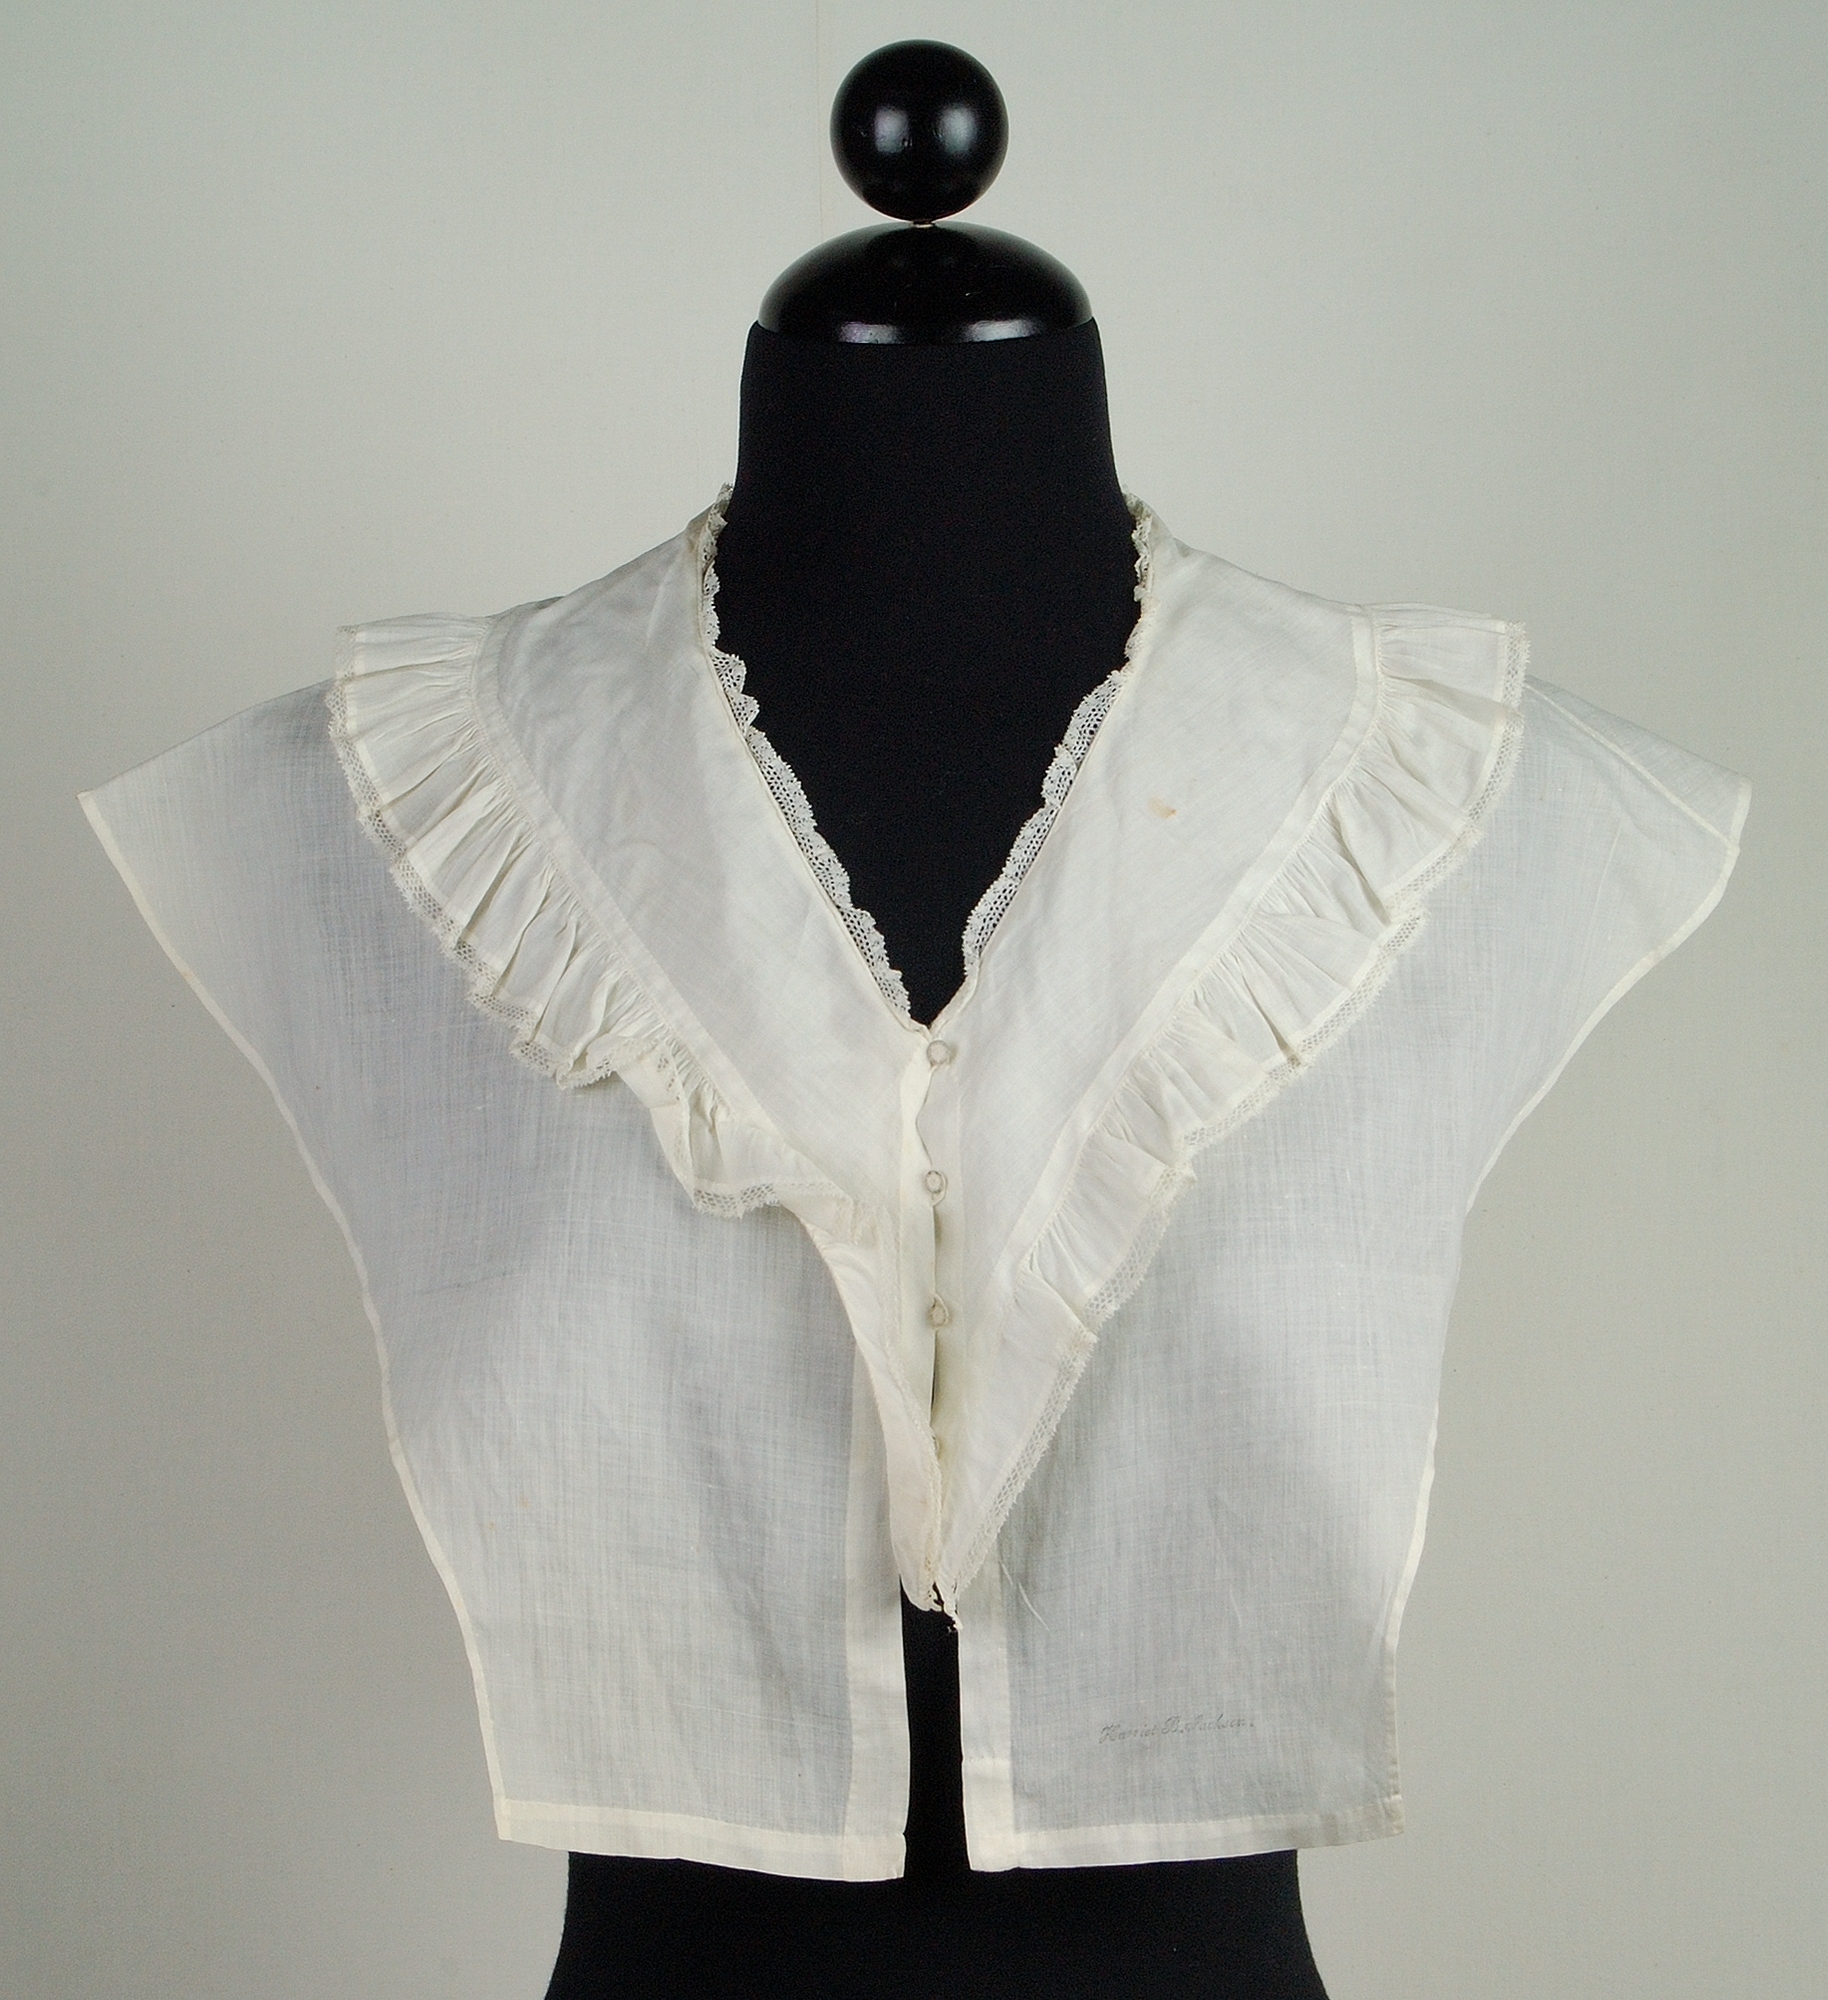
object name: chemise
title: Chemisette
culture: american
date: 1876-1900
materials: cotton